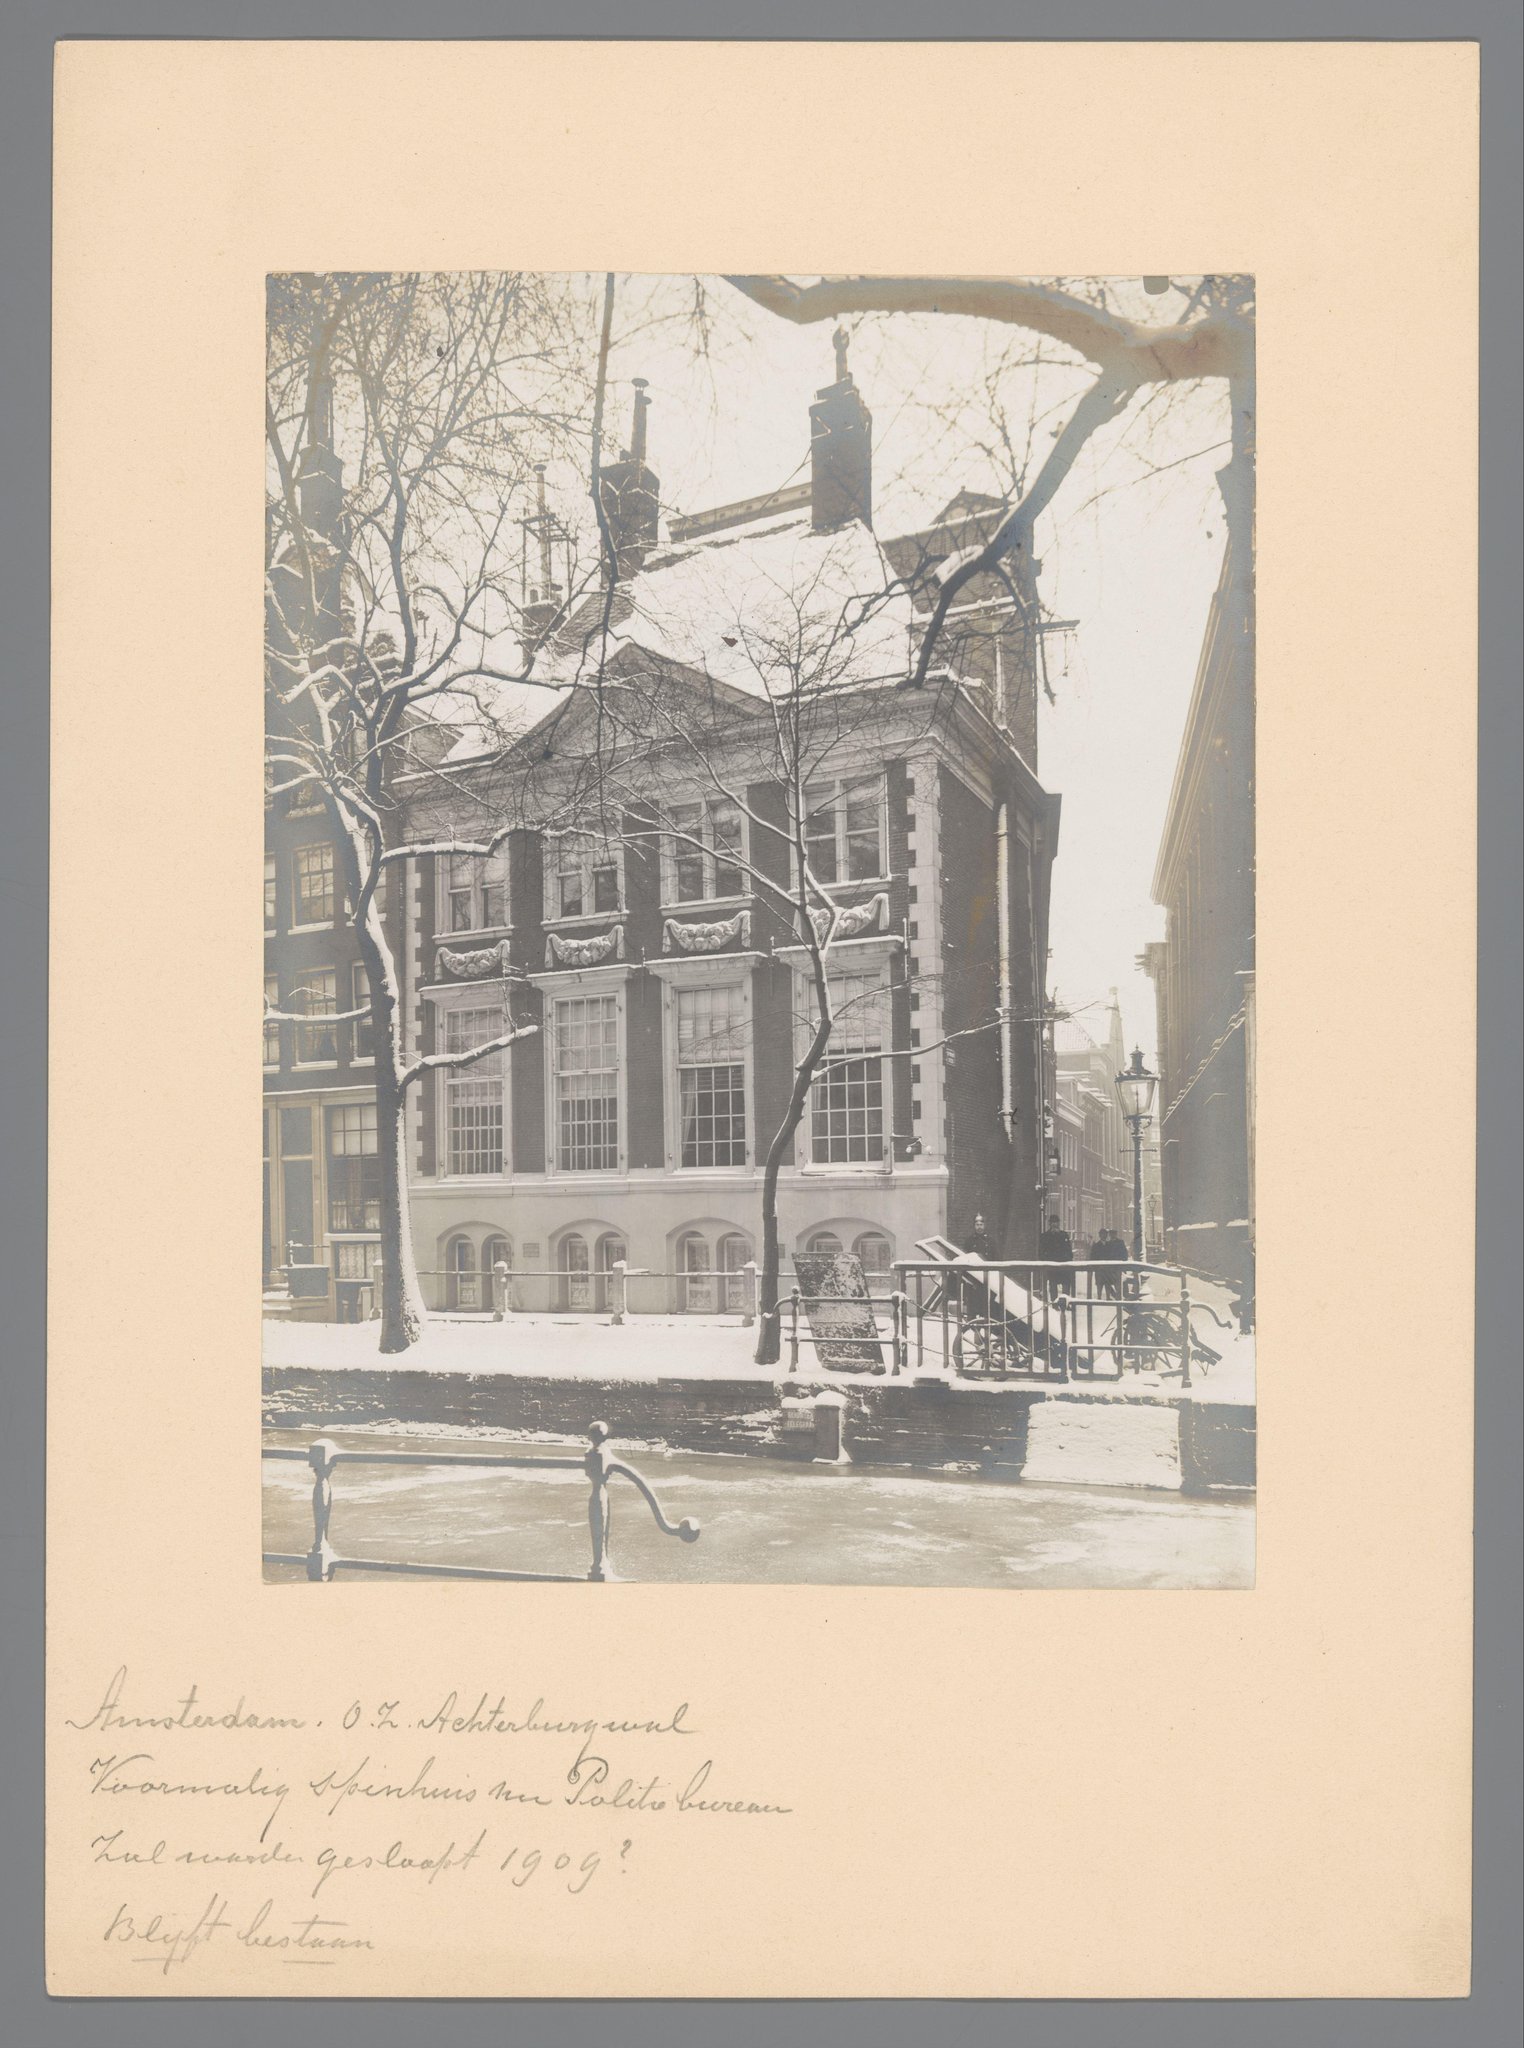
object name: photograph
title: Gezicht op het oude Spinhuis aan de Oudezijds Achterburgwal te Amsterdam, in de winter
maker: Anonymous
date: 1900-1920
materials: cardboard, photographic support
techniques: gelatin silver print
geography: amsterdam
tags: façade (of house or building), civic architecture; edifices; dwellings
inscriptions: annotation: ‘Amsterdam, O.Z. Achterburgwal/ Voormalig Spinhuis nu Politiebureau/ zal worden gesloopt 1909?/ Blijft bestaan’